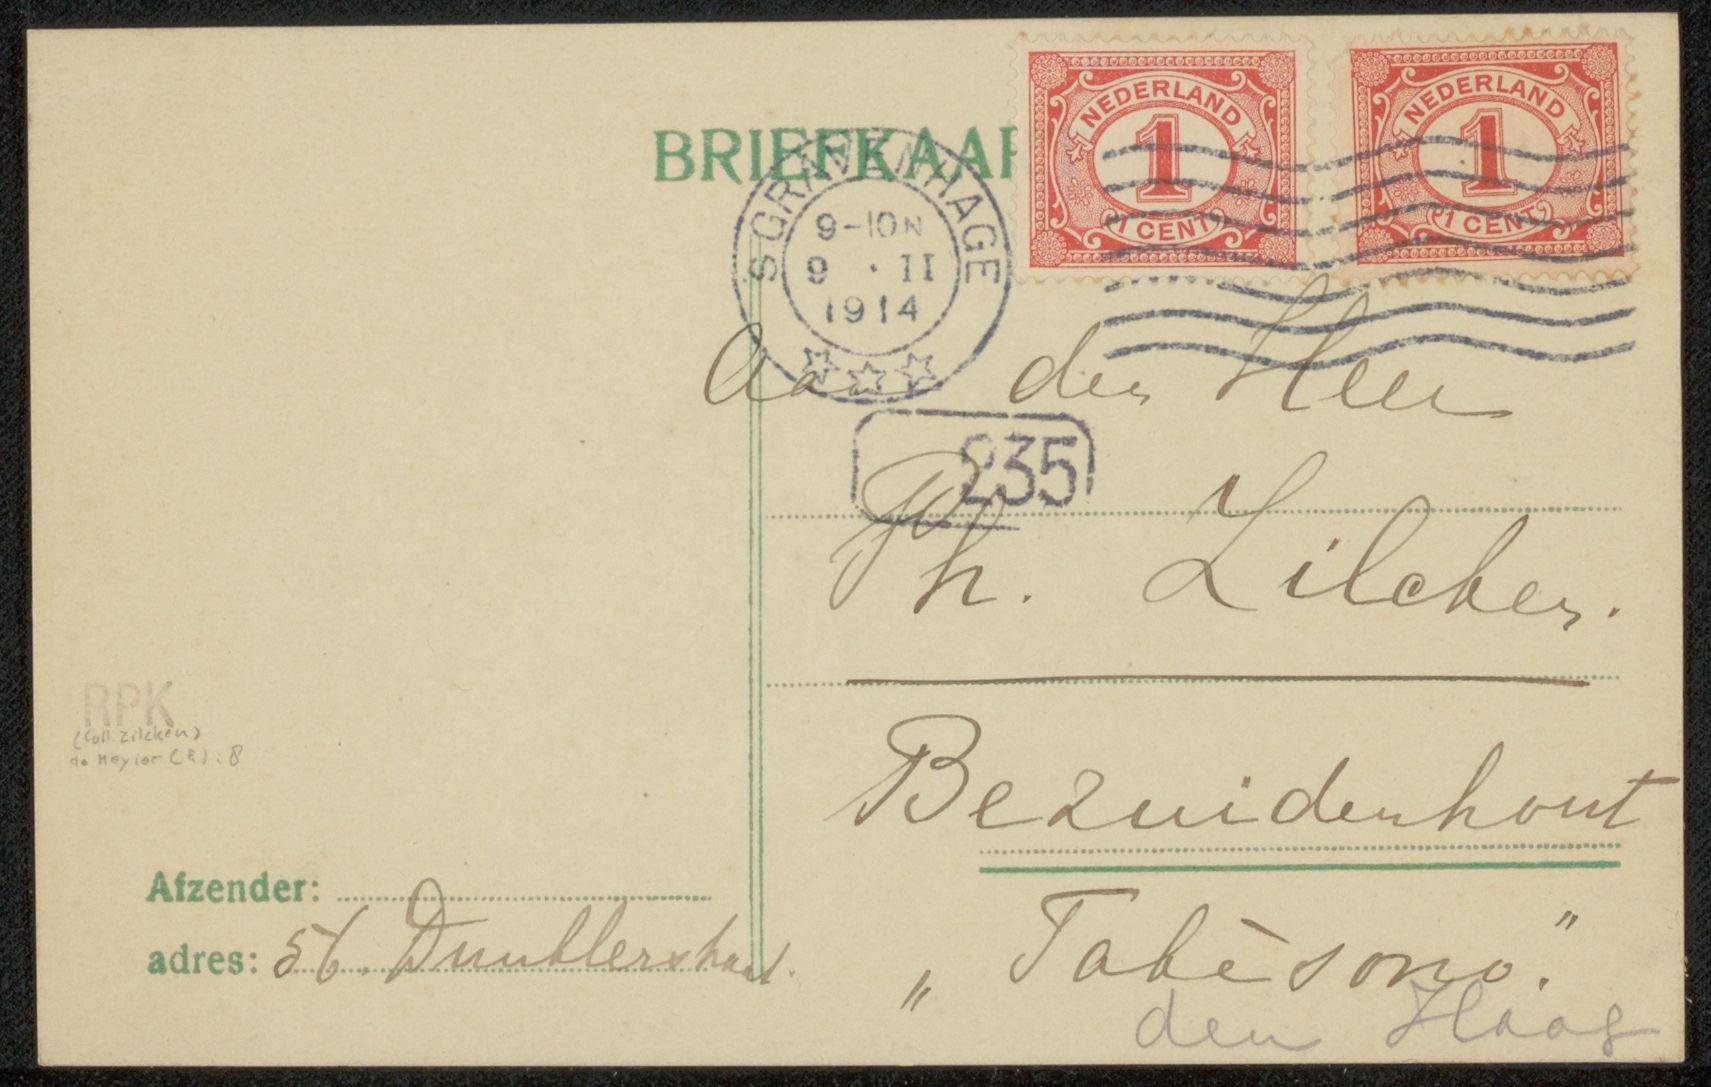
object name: postcard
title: Briefkaart aan Philip Zilcken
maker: fenna de meyier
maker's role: onderwijzer, schrijver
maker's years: 1874-1943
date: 1914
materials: cardboard, ink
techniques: pen, writing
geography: the hague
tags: painter, draughtsman, philip zilcken, printed matter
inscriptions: collector's mark: ‘RPK’